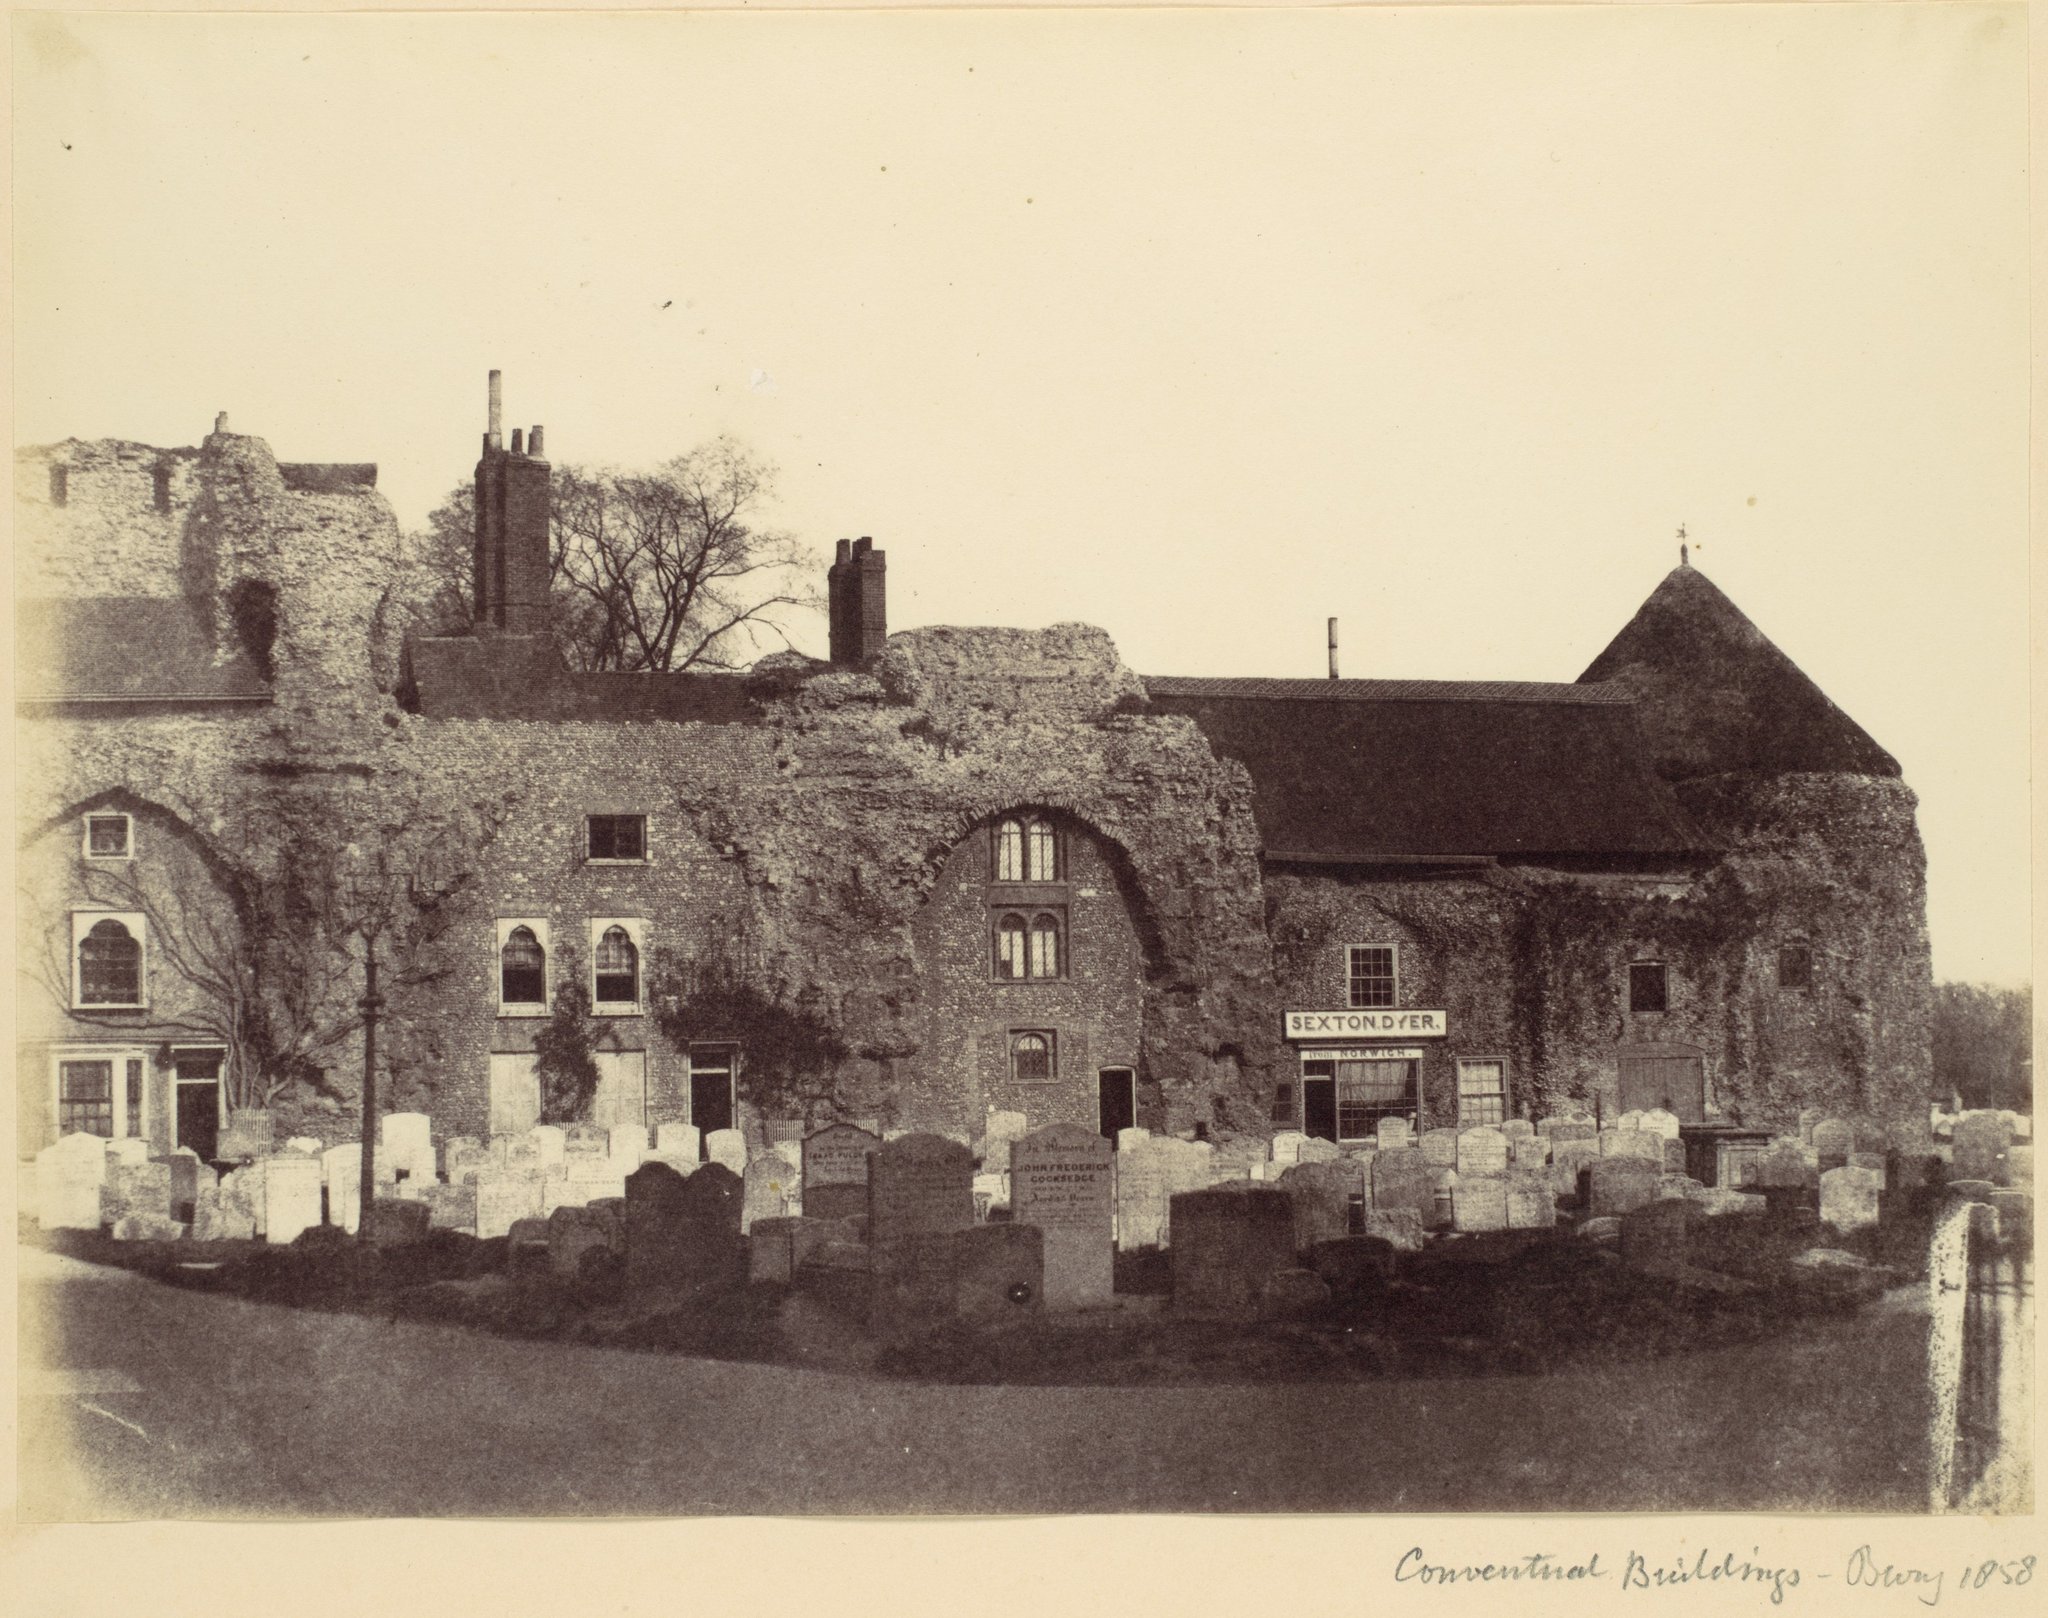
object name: photograph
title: Conventual Buildings, Bury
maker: alfred capel cure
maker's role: artist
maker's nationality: british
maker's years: 1826-1896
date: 1858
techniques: albumen silver print, paper negative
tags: architecture,buildings